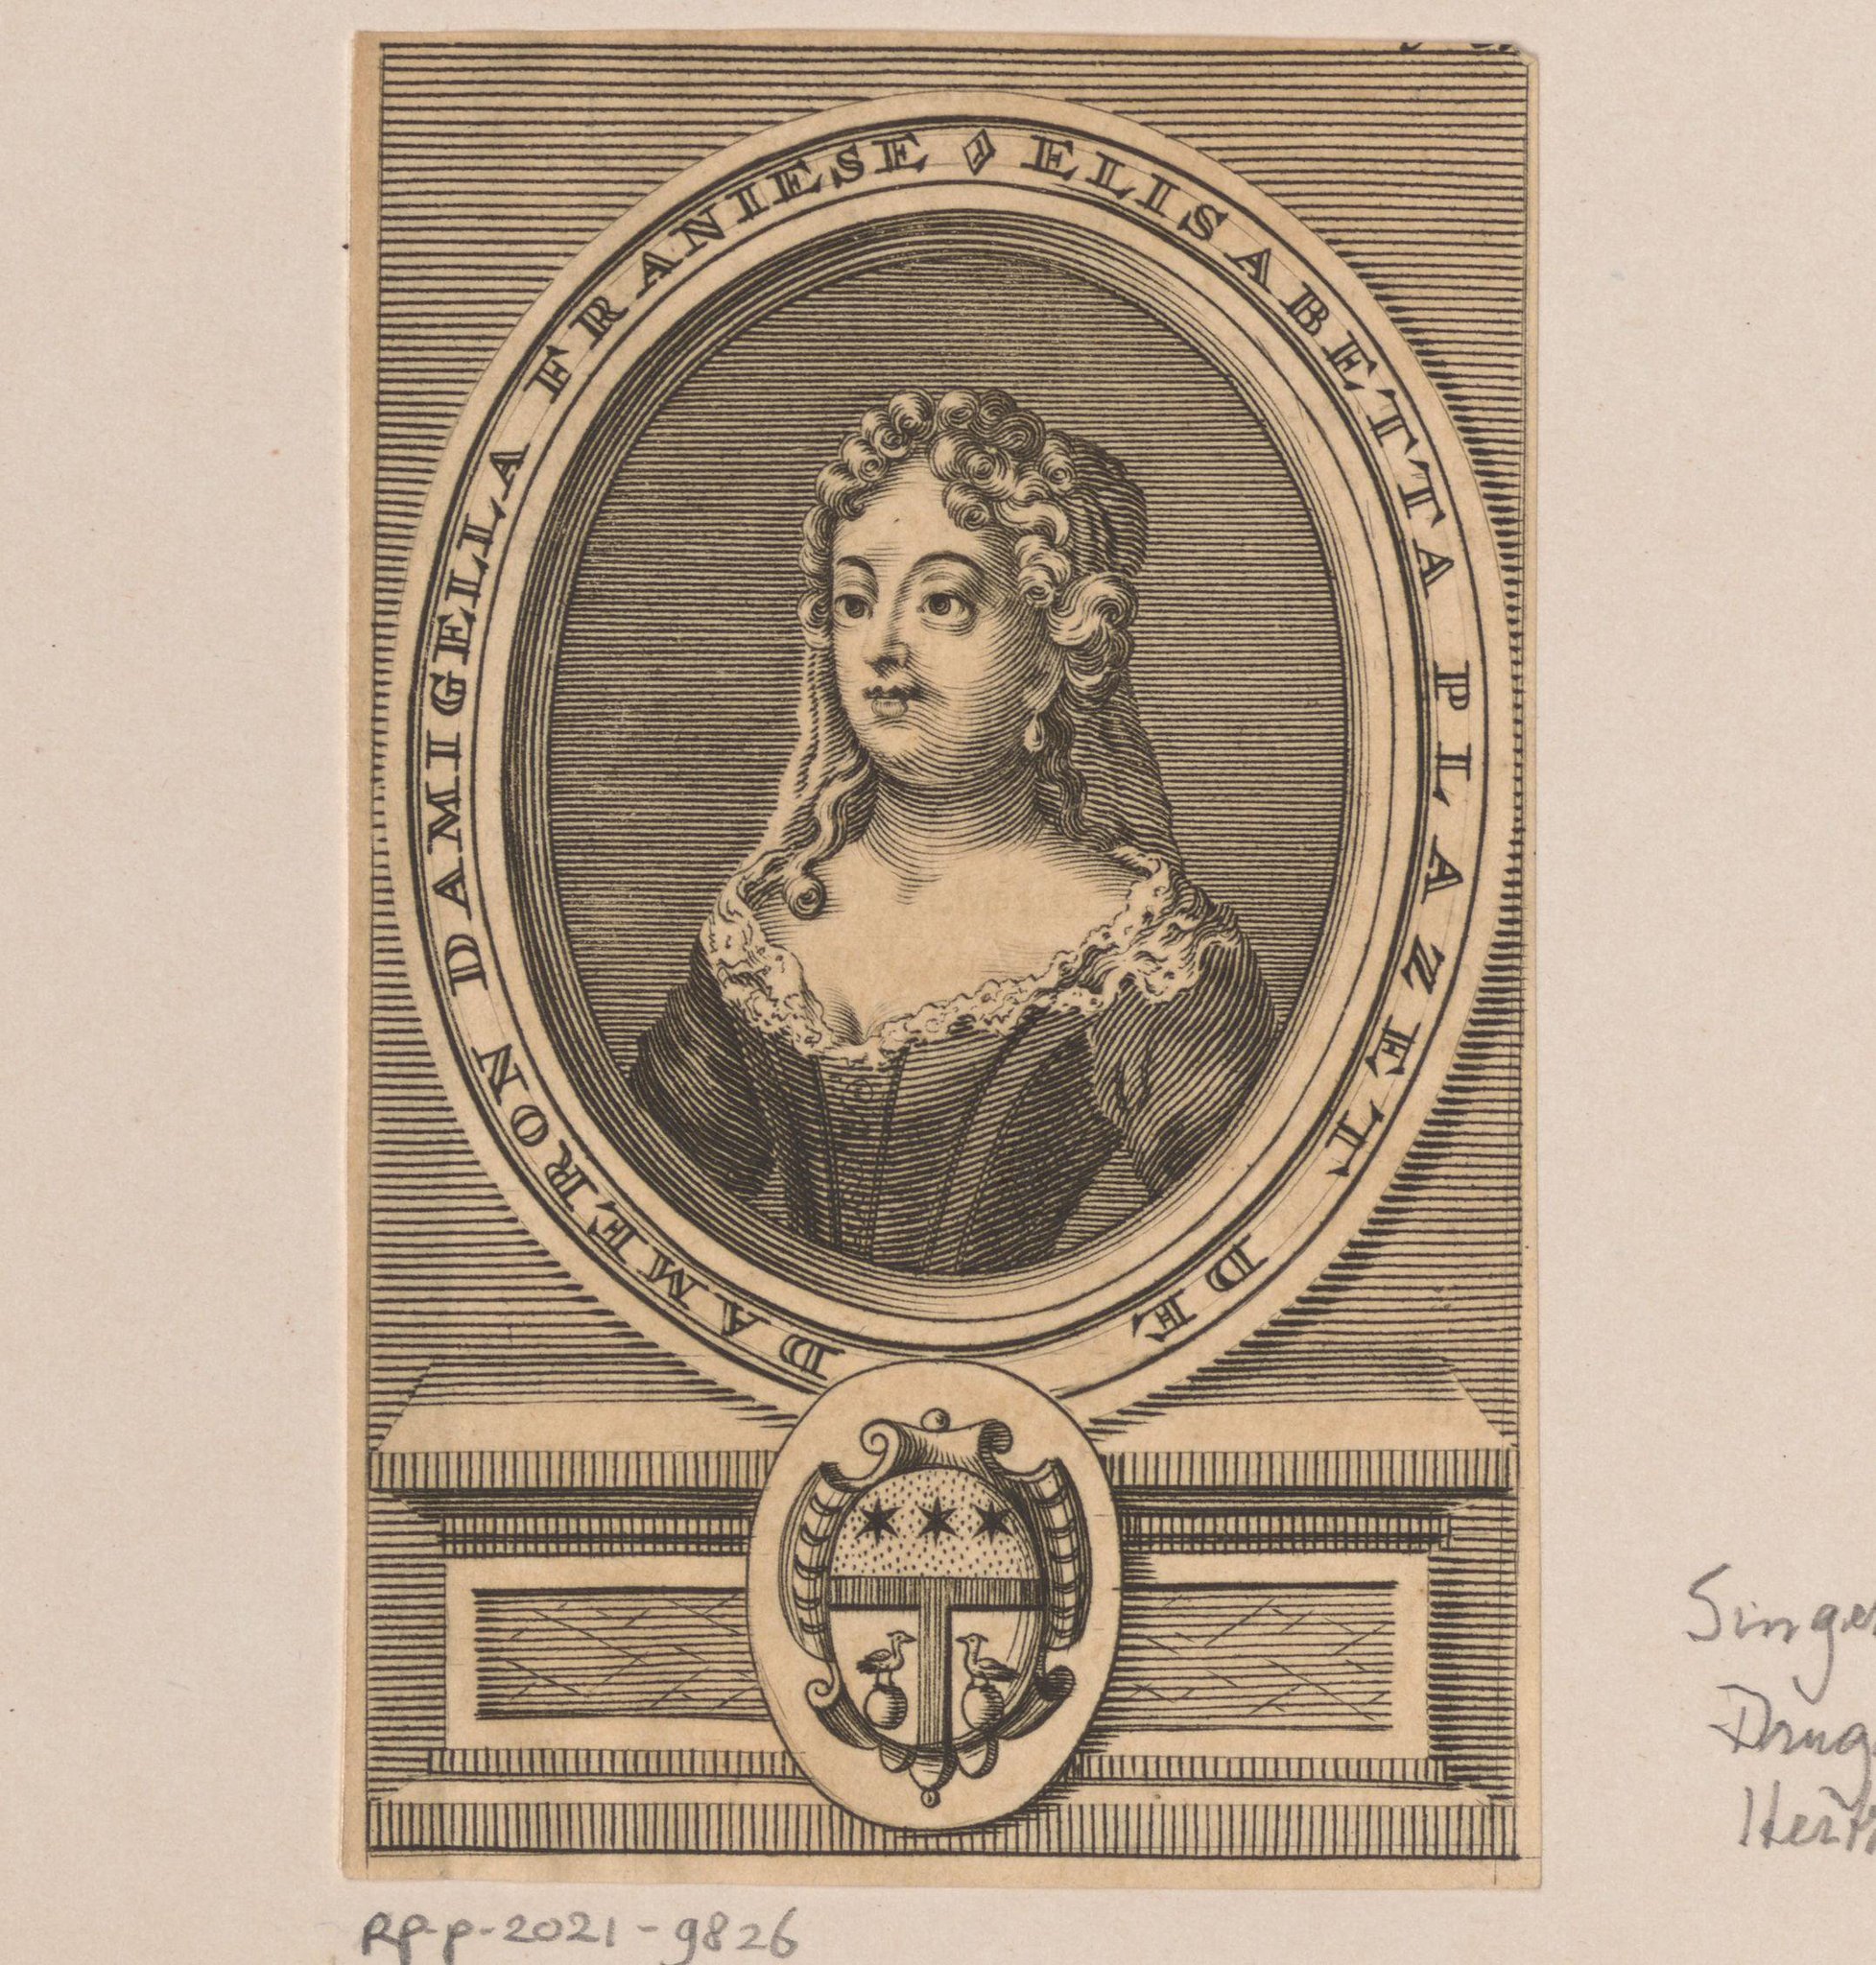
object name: print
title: Portret van Elisabeth Plazet de Dameron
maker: Anonymous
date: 1694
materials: paper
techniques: engraving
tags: adult woman, historical persons, armorial bearing, heraldry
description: Prent waarschijnlijk uit: Leti, Gregorio. La vie d'Elizabeth reine d'Angleterre. Amsterdam: Henri Desbordes, 1694, dl. 2. Latere staat gebruikt in: Leti, Gregorio. Historia overo Vita di Elisabetta, Regina d'Inghilterra: Detta per sopranome la comediante politica. Amsterdam: Pieter Mortier, 1703, dl. 2.